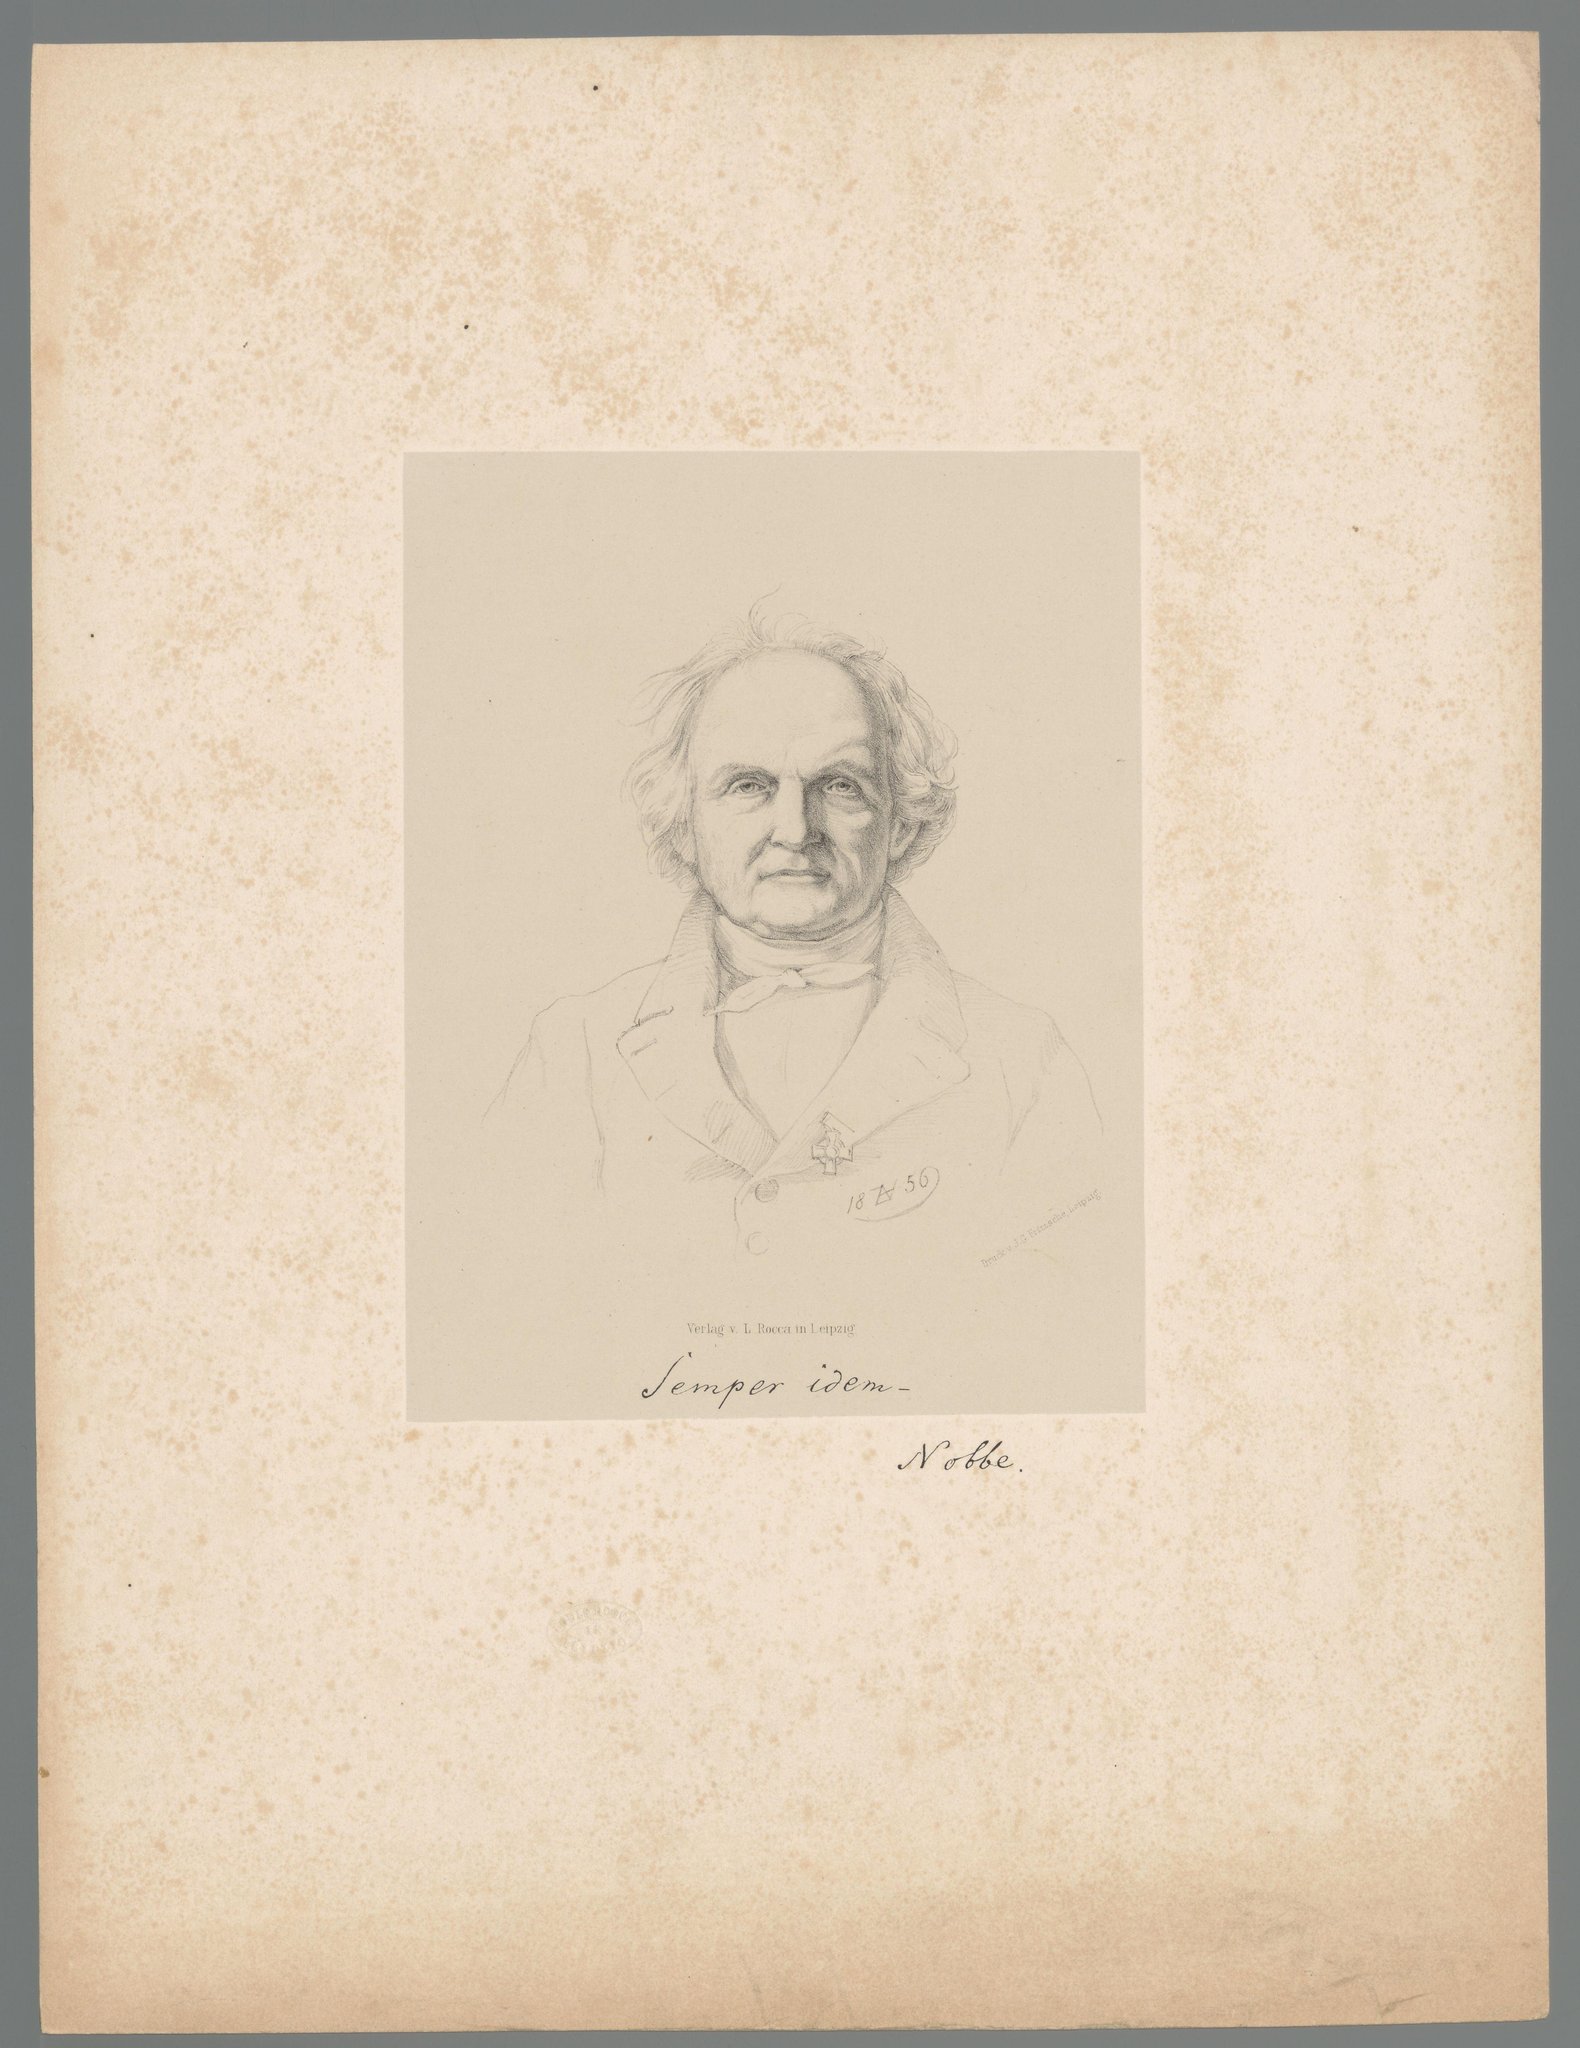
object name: print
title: Portret van Karl Friedrich August Nobbe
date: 1856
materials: paper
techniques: lithograph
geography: leipzig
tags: adult man, historical persons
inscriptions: check stamp: ‘Louis Rocca in Leipzig’